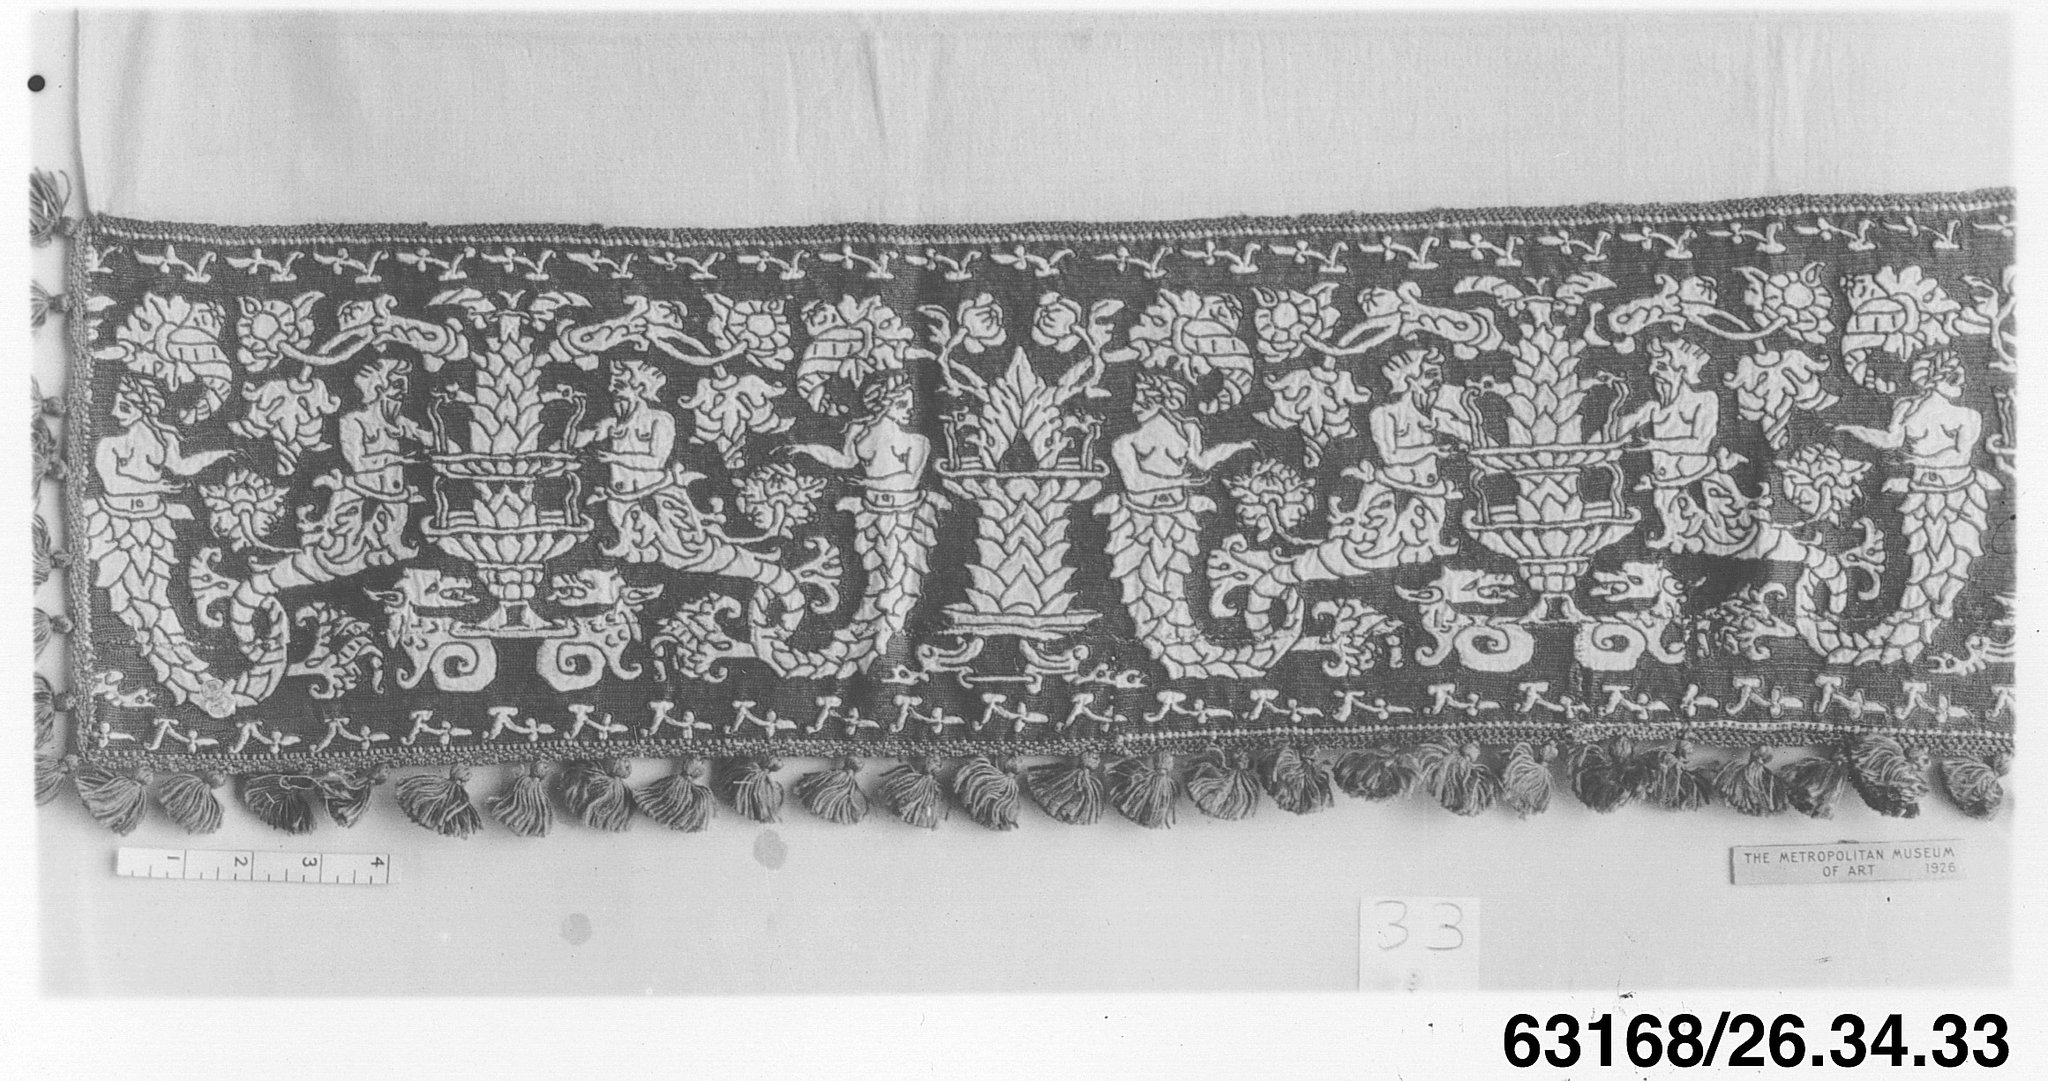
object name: strip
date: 1601-1800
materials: linen, silk